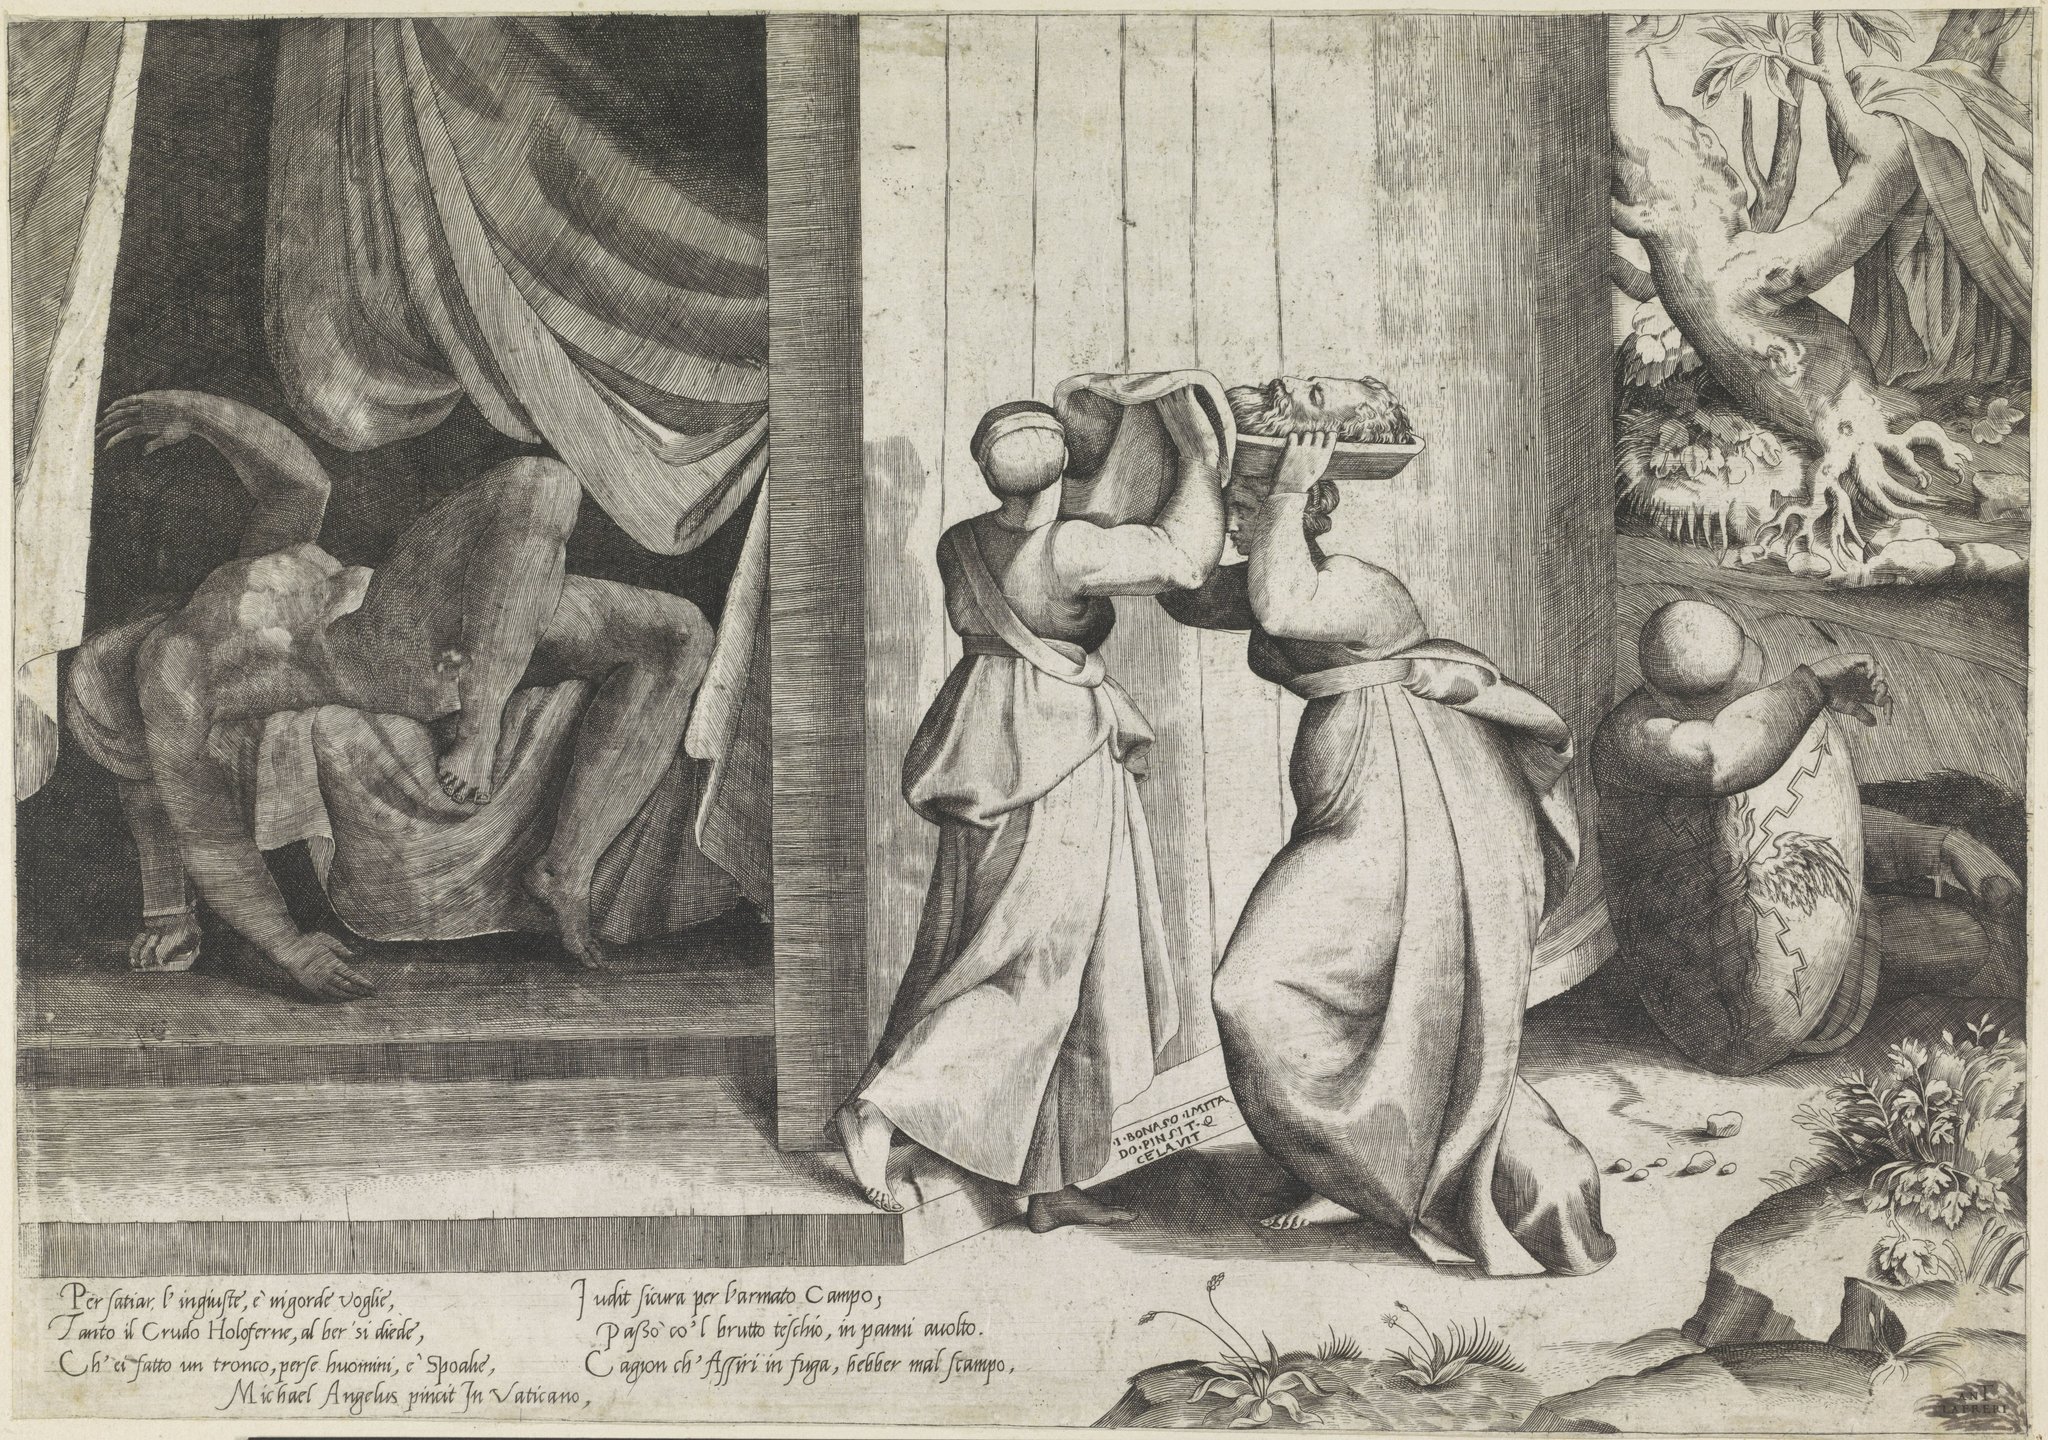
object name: print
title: Judit en haar dienstmaagd stoppen het hoofd van Holofernes in een zak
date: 1501-1580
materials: paper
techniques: engraving, etching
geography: italy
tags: judith and her maidservant put holofernes' head in a sack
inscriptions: collector's mark: Lugt 240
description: Judit en haar dienstmaagd stoppen het afgehakte hoofd van Holofernes in een zak. Op de achtergrond links ligt het dode lichaam van Holofernes in een tent. Rechts zit een bewaker achter zijn schild tegen de tent. Italiaans vers linksonder.